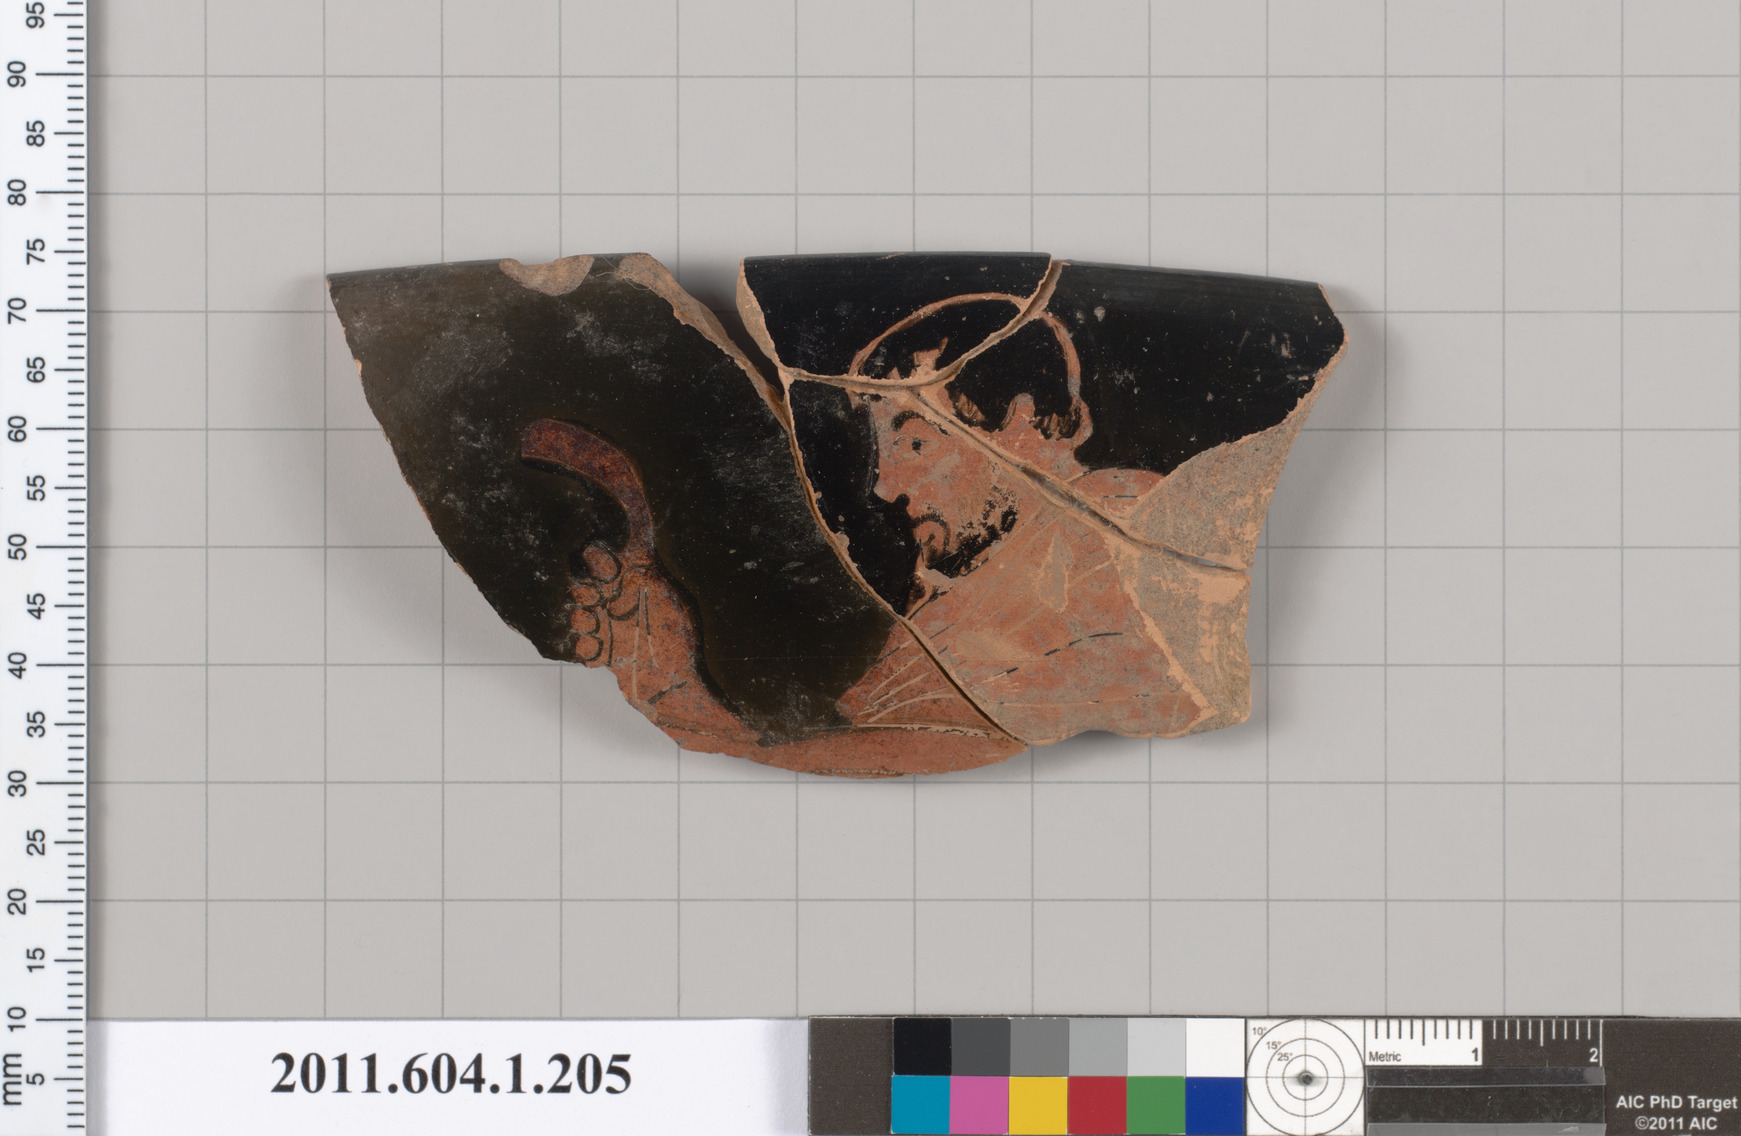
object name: kylix fragment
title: Terracotta rim fragment of a kylix (drinking cup)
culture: greek, attic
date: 475-451 BCE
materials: terracotta